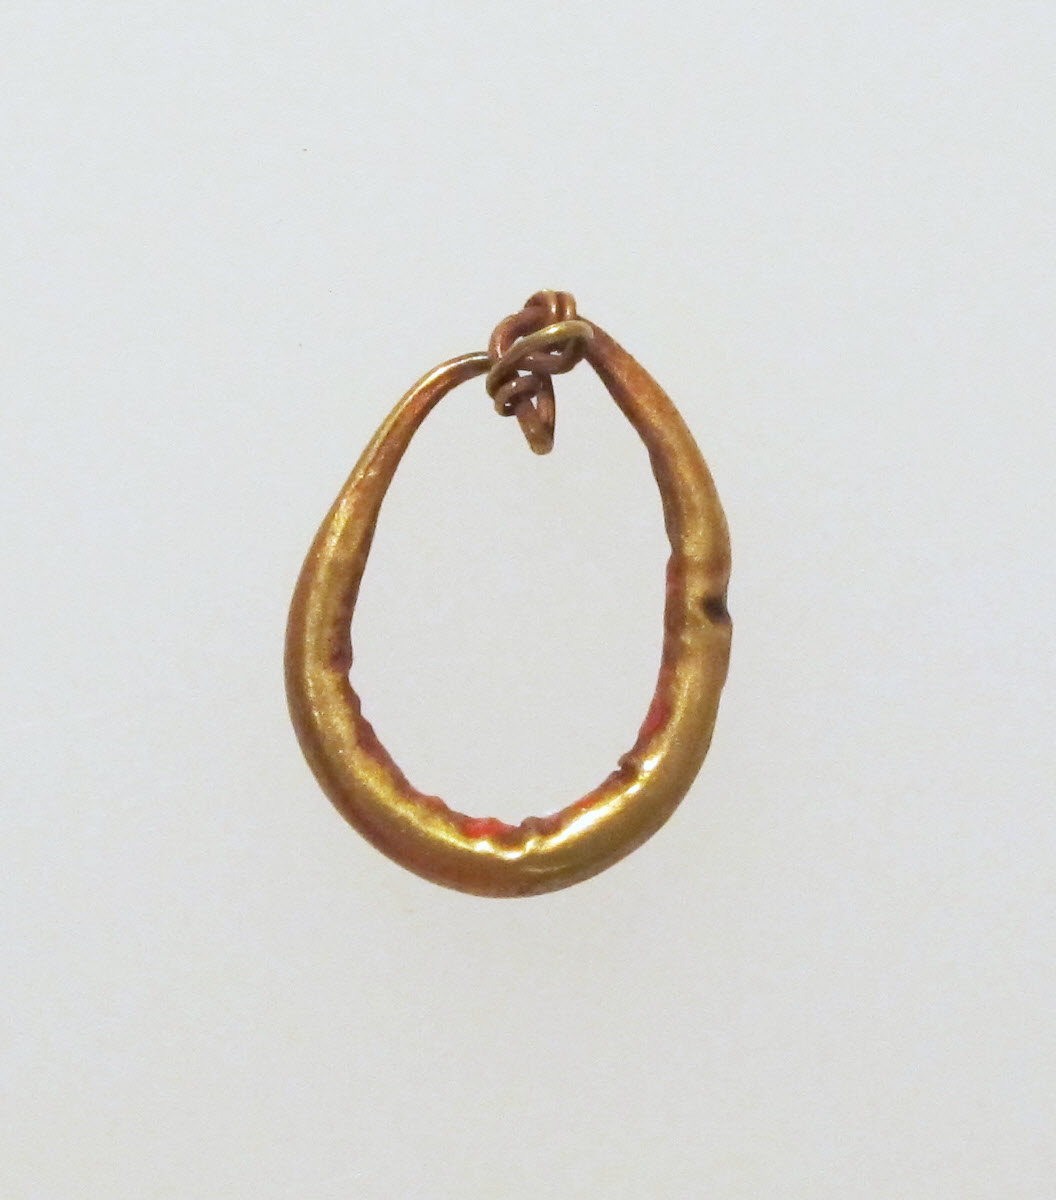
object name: earring loop type, plain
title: Earring-loop type, plain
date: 7000 BCE-330 CE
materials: gold